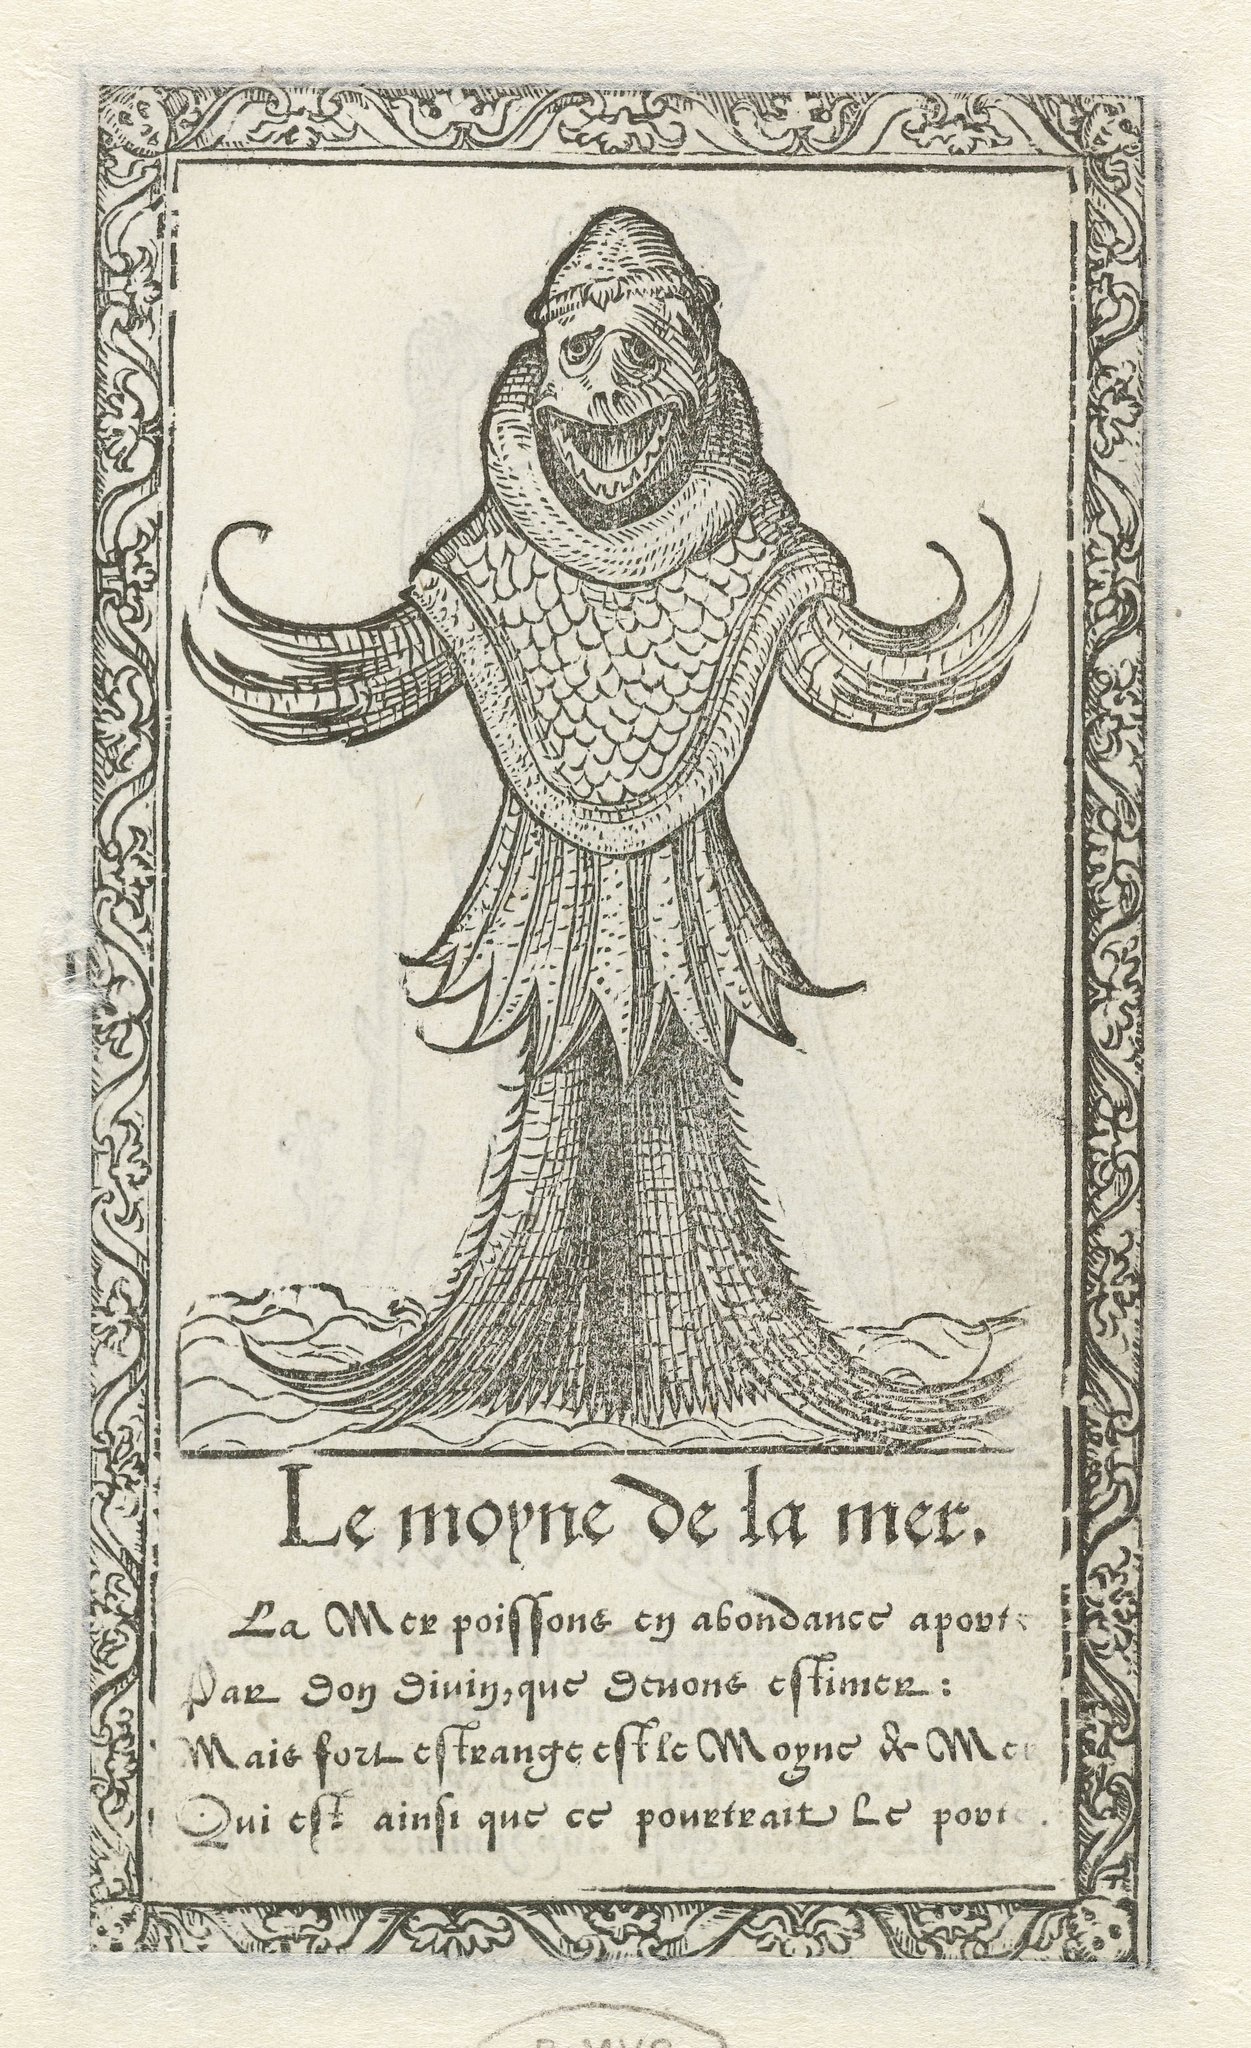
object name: print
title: Recueil de la diversité des habits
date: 1562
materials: paper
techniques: woodcut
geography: paris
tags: monsters of mixed human and animal shape; 'mostri' (ripa), monsters of the sea, monk(s), friar(s), folk costume, regional costume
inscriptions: collector's mark: Lugt 2228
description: Dit is prent 51 uit een serie van 121. Binnen deze serie zijn er prenten gemaakt naar voorbeelden van Jean-François de Roberval en Enea Vico, onbekend welke precies.